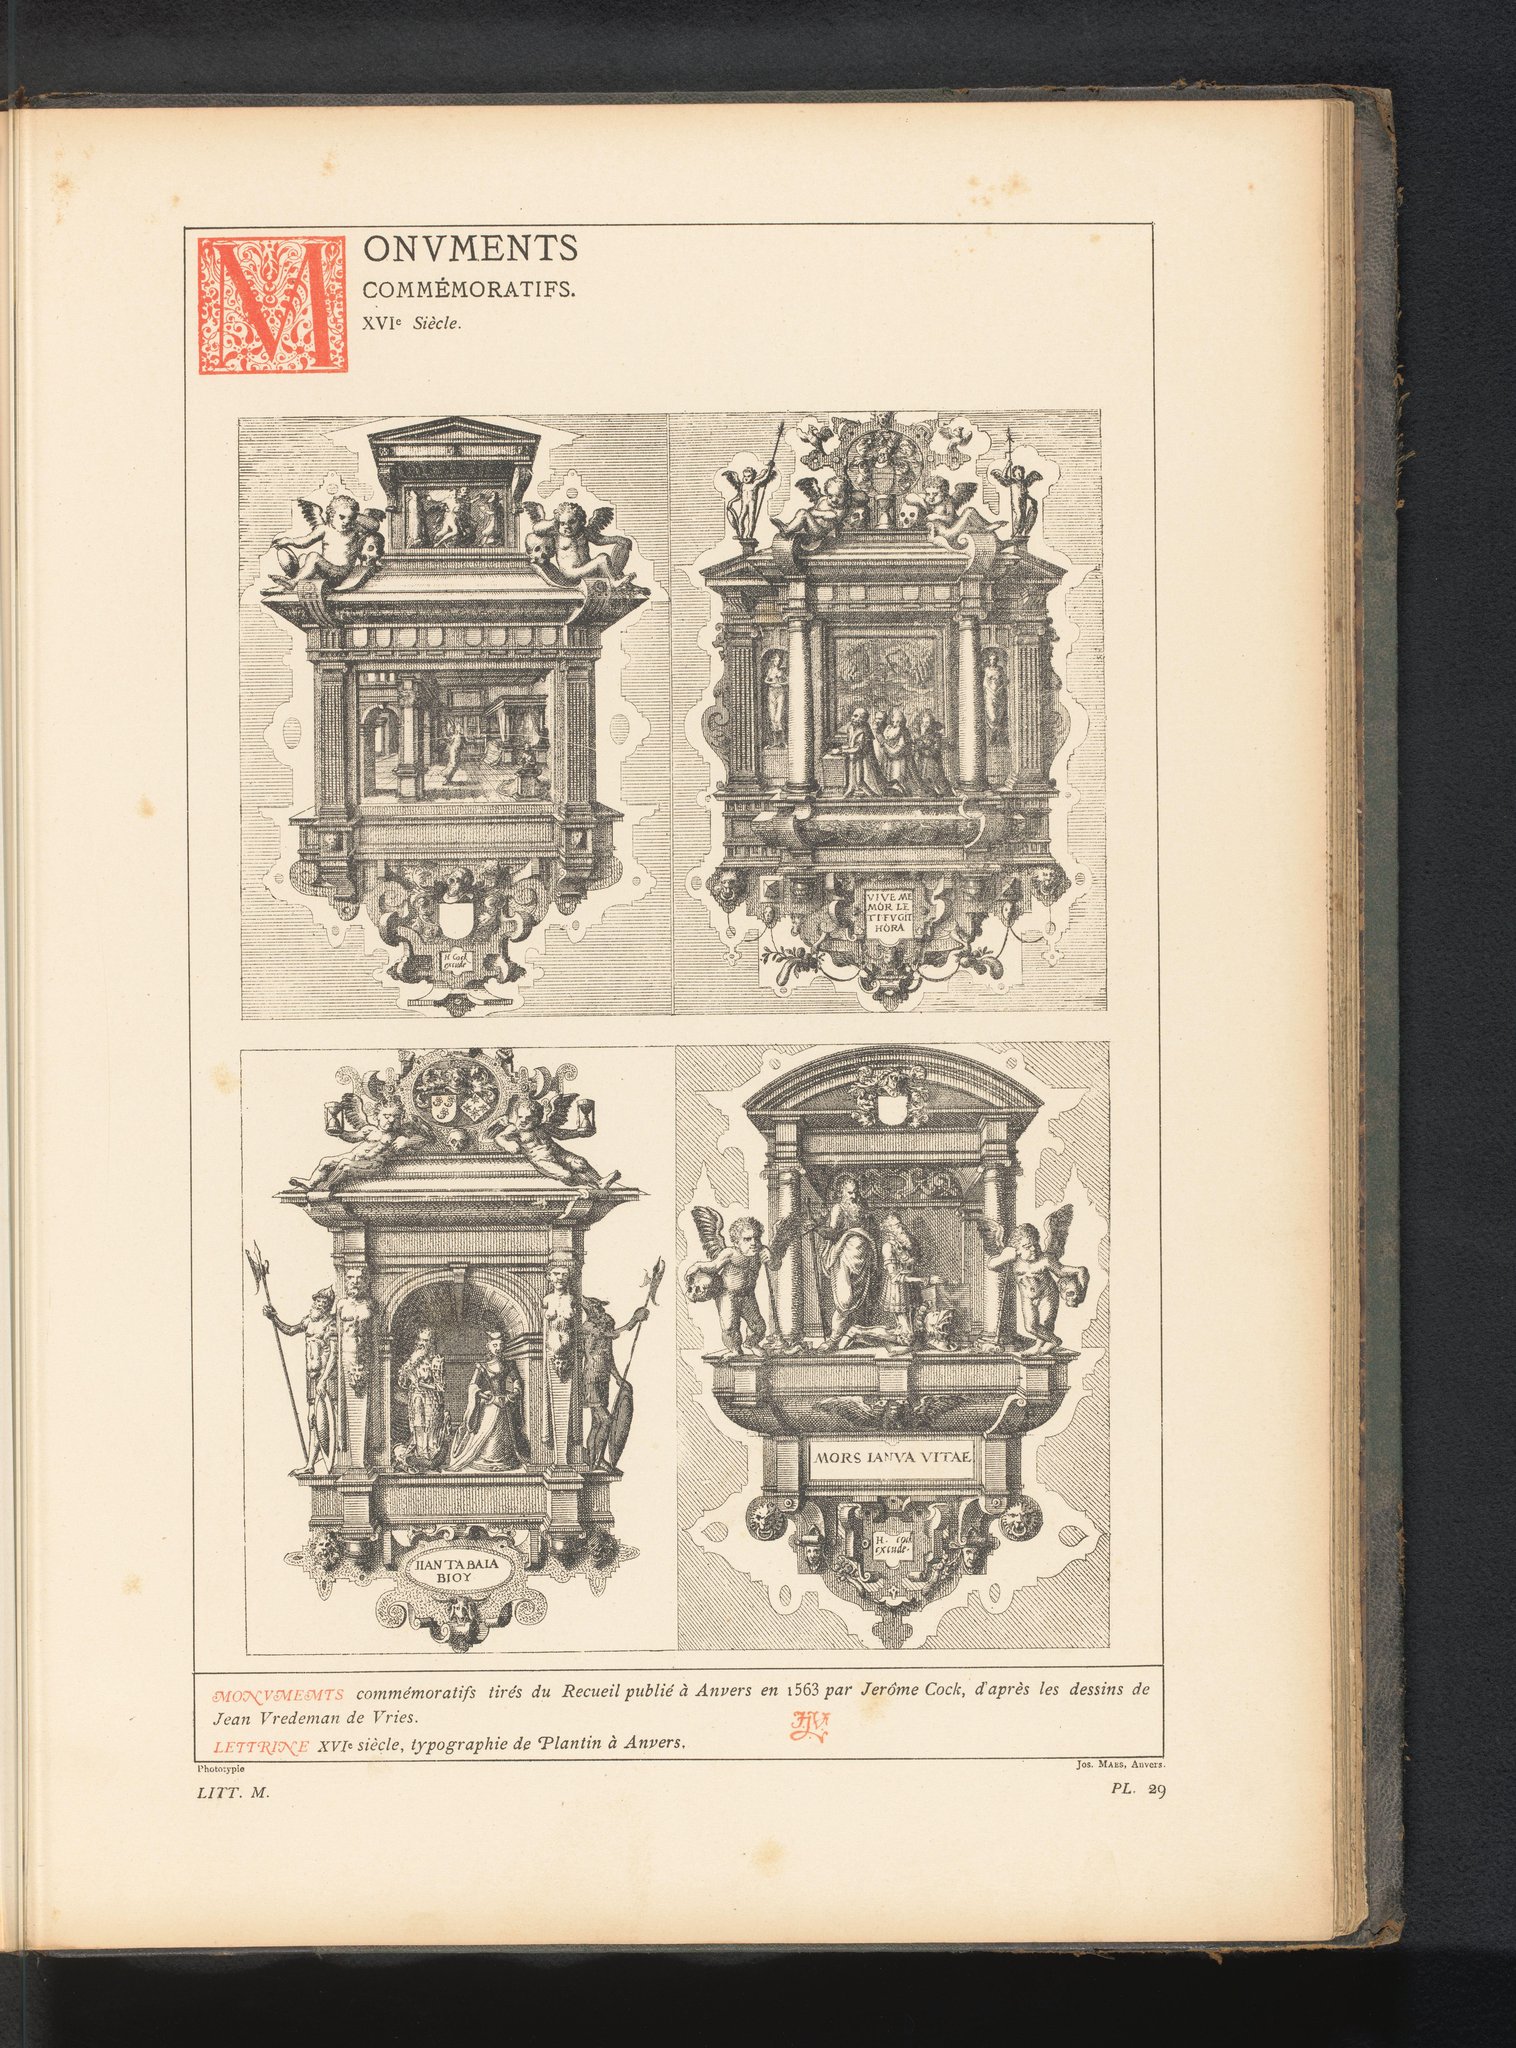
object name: reproduction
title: Monuments Commémoratifs, XVIe Siècle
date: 1875-1880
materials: paper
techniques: photolithography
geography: antwerp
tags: bible, commemoration, jubilee, cupids: 'amores', 'amoretti', 'putti'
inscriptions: inscription: ‘LITT. M. - PL. 29’, monogram: ‘JJvY’, inscription: ‘MONUMENTS commémoratifs tirés (...)’